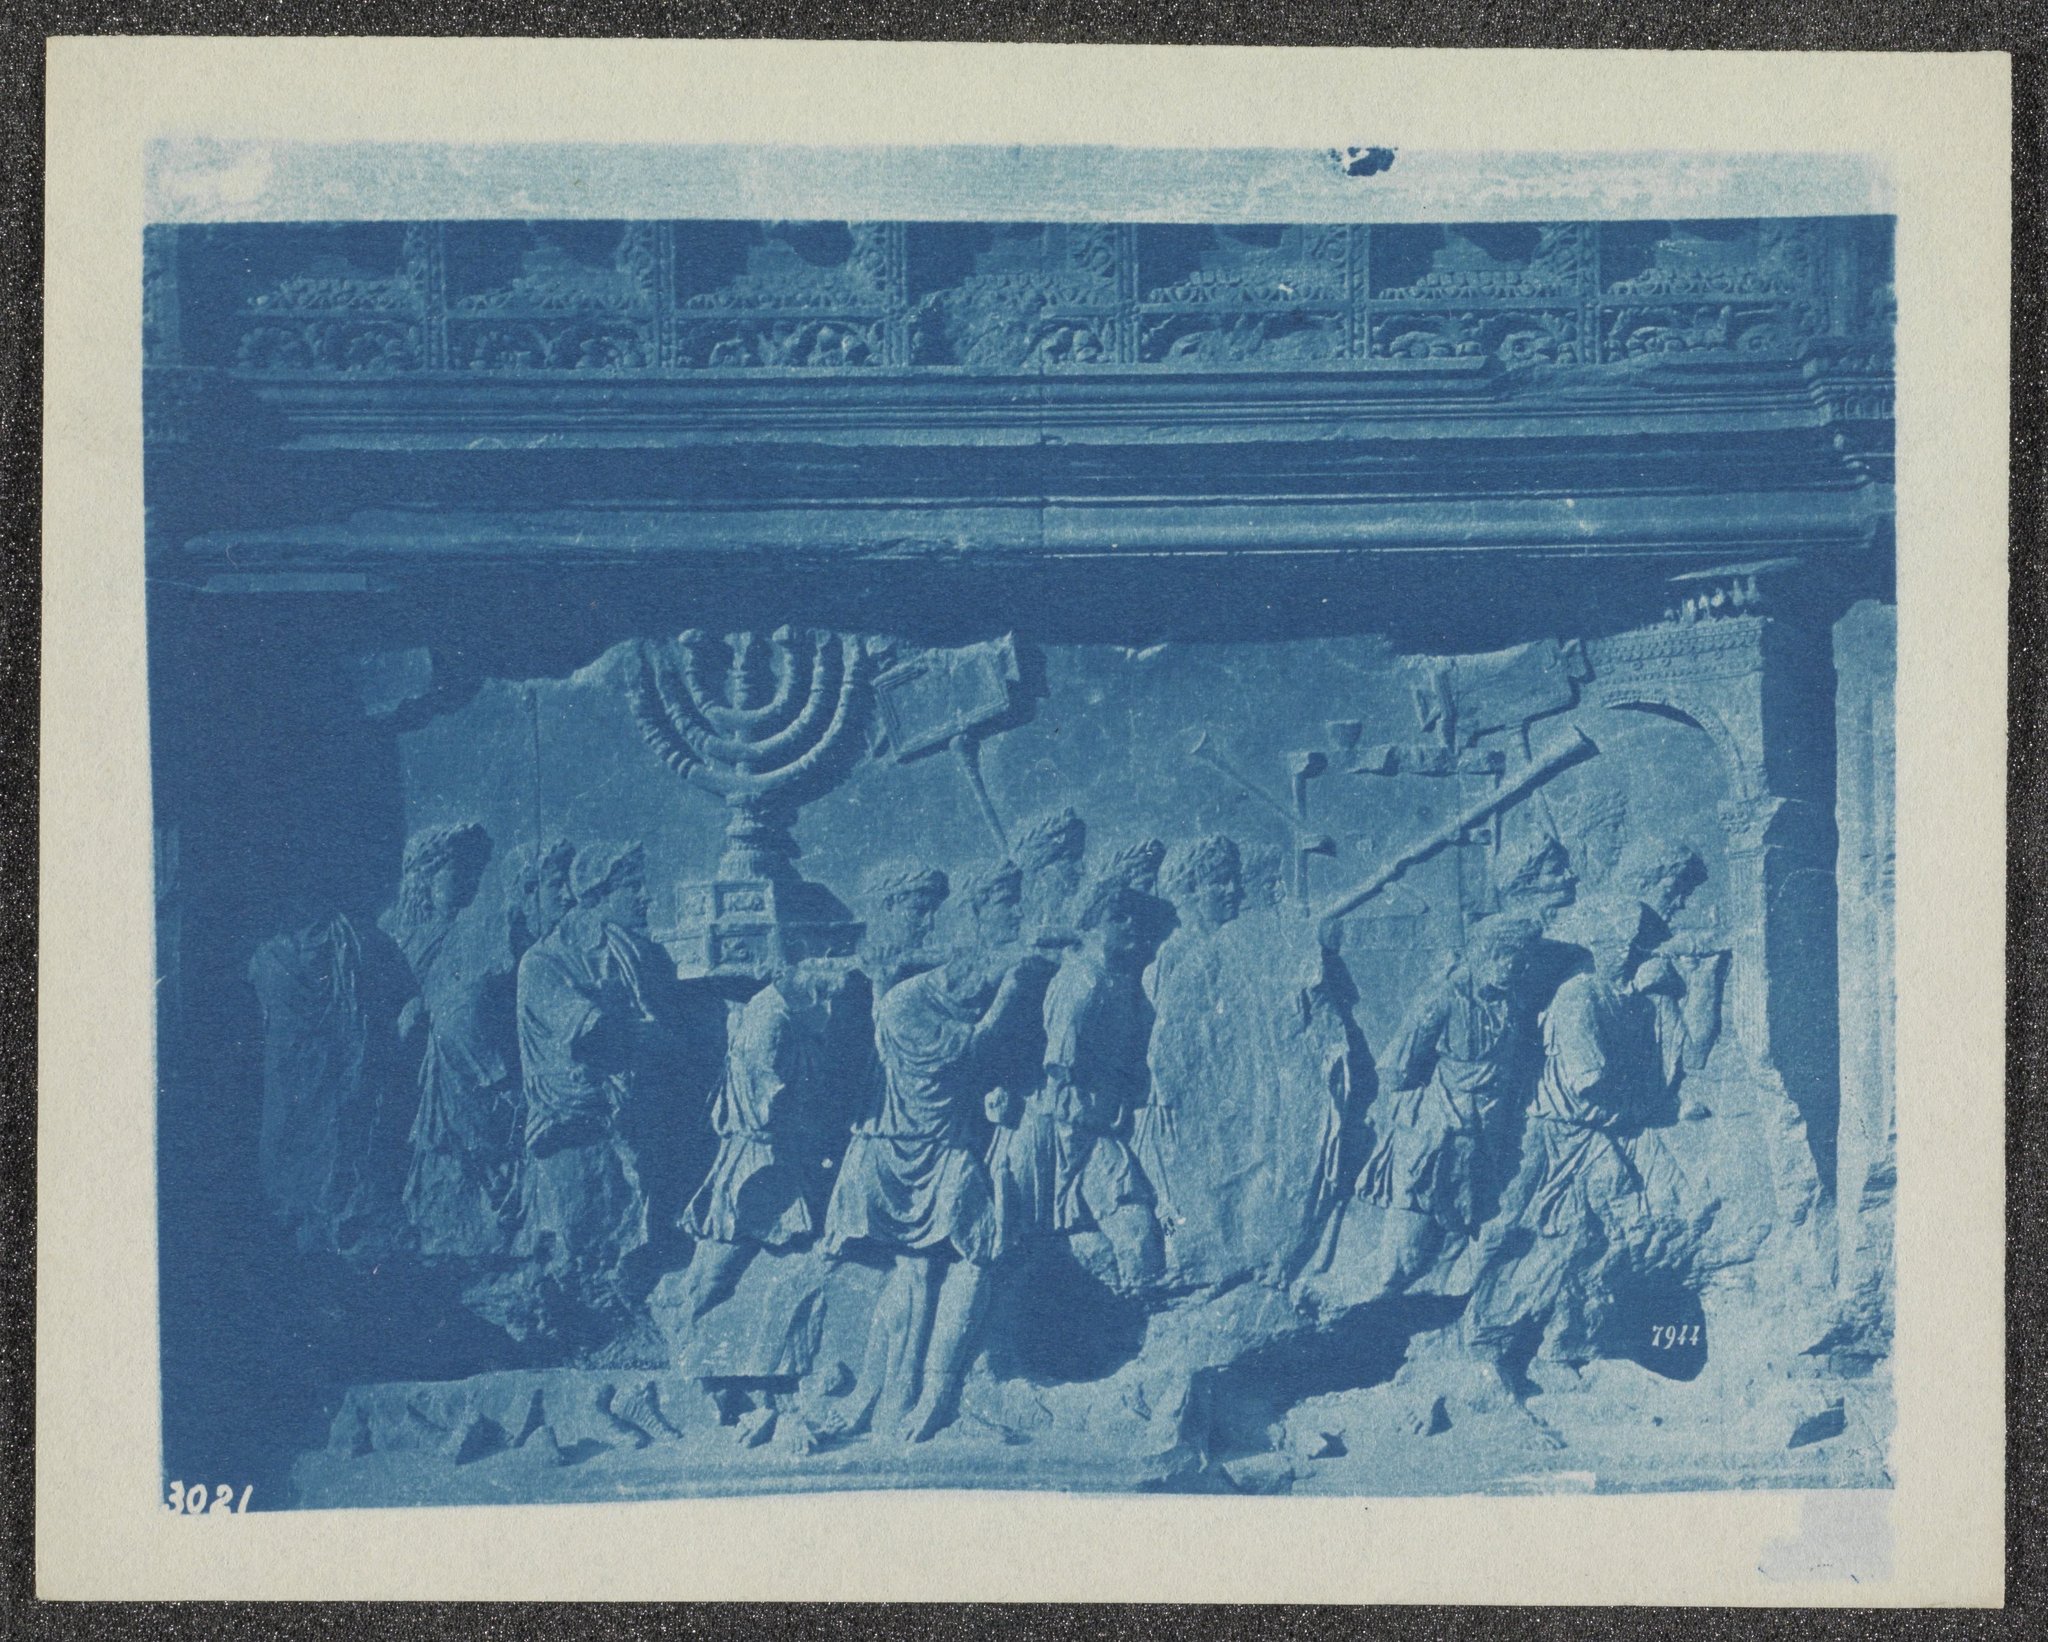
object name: photograph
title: Fotoreproductie van een foto van een reliëf op de Boog van Titus te Rome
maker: Anonymous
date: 1880-1905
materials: paper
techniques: cyanotype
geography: rome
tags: art (+ relief ~ sculpture)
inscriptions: inscription: ‘Relief on Arch of Titus/ Rome’, number: ‘3021’